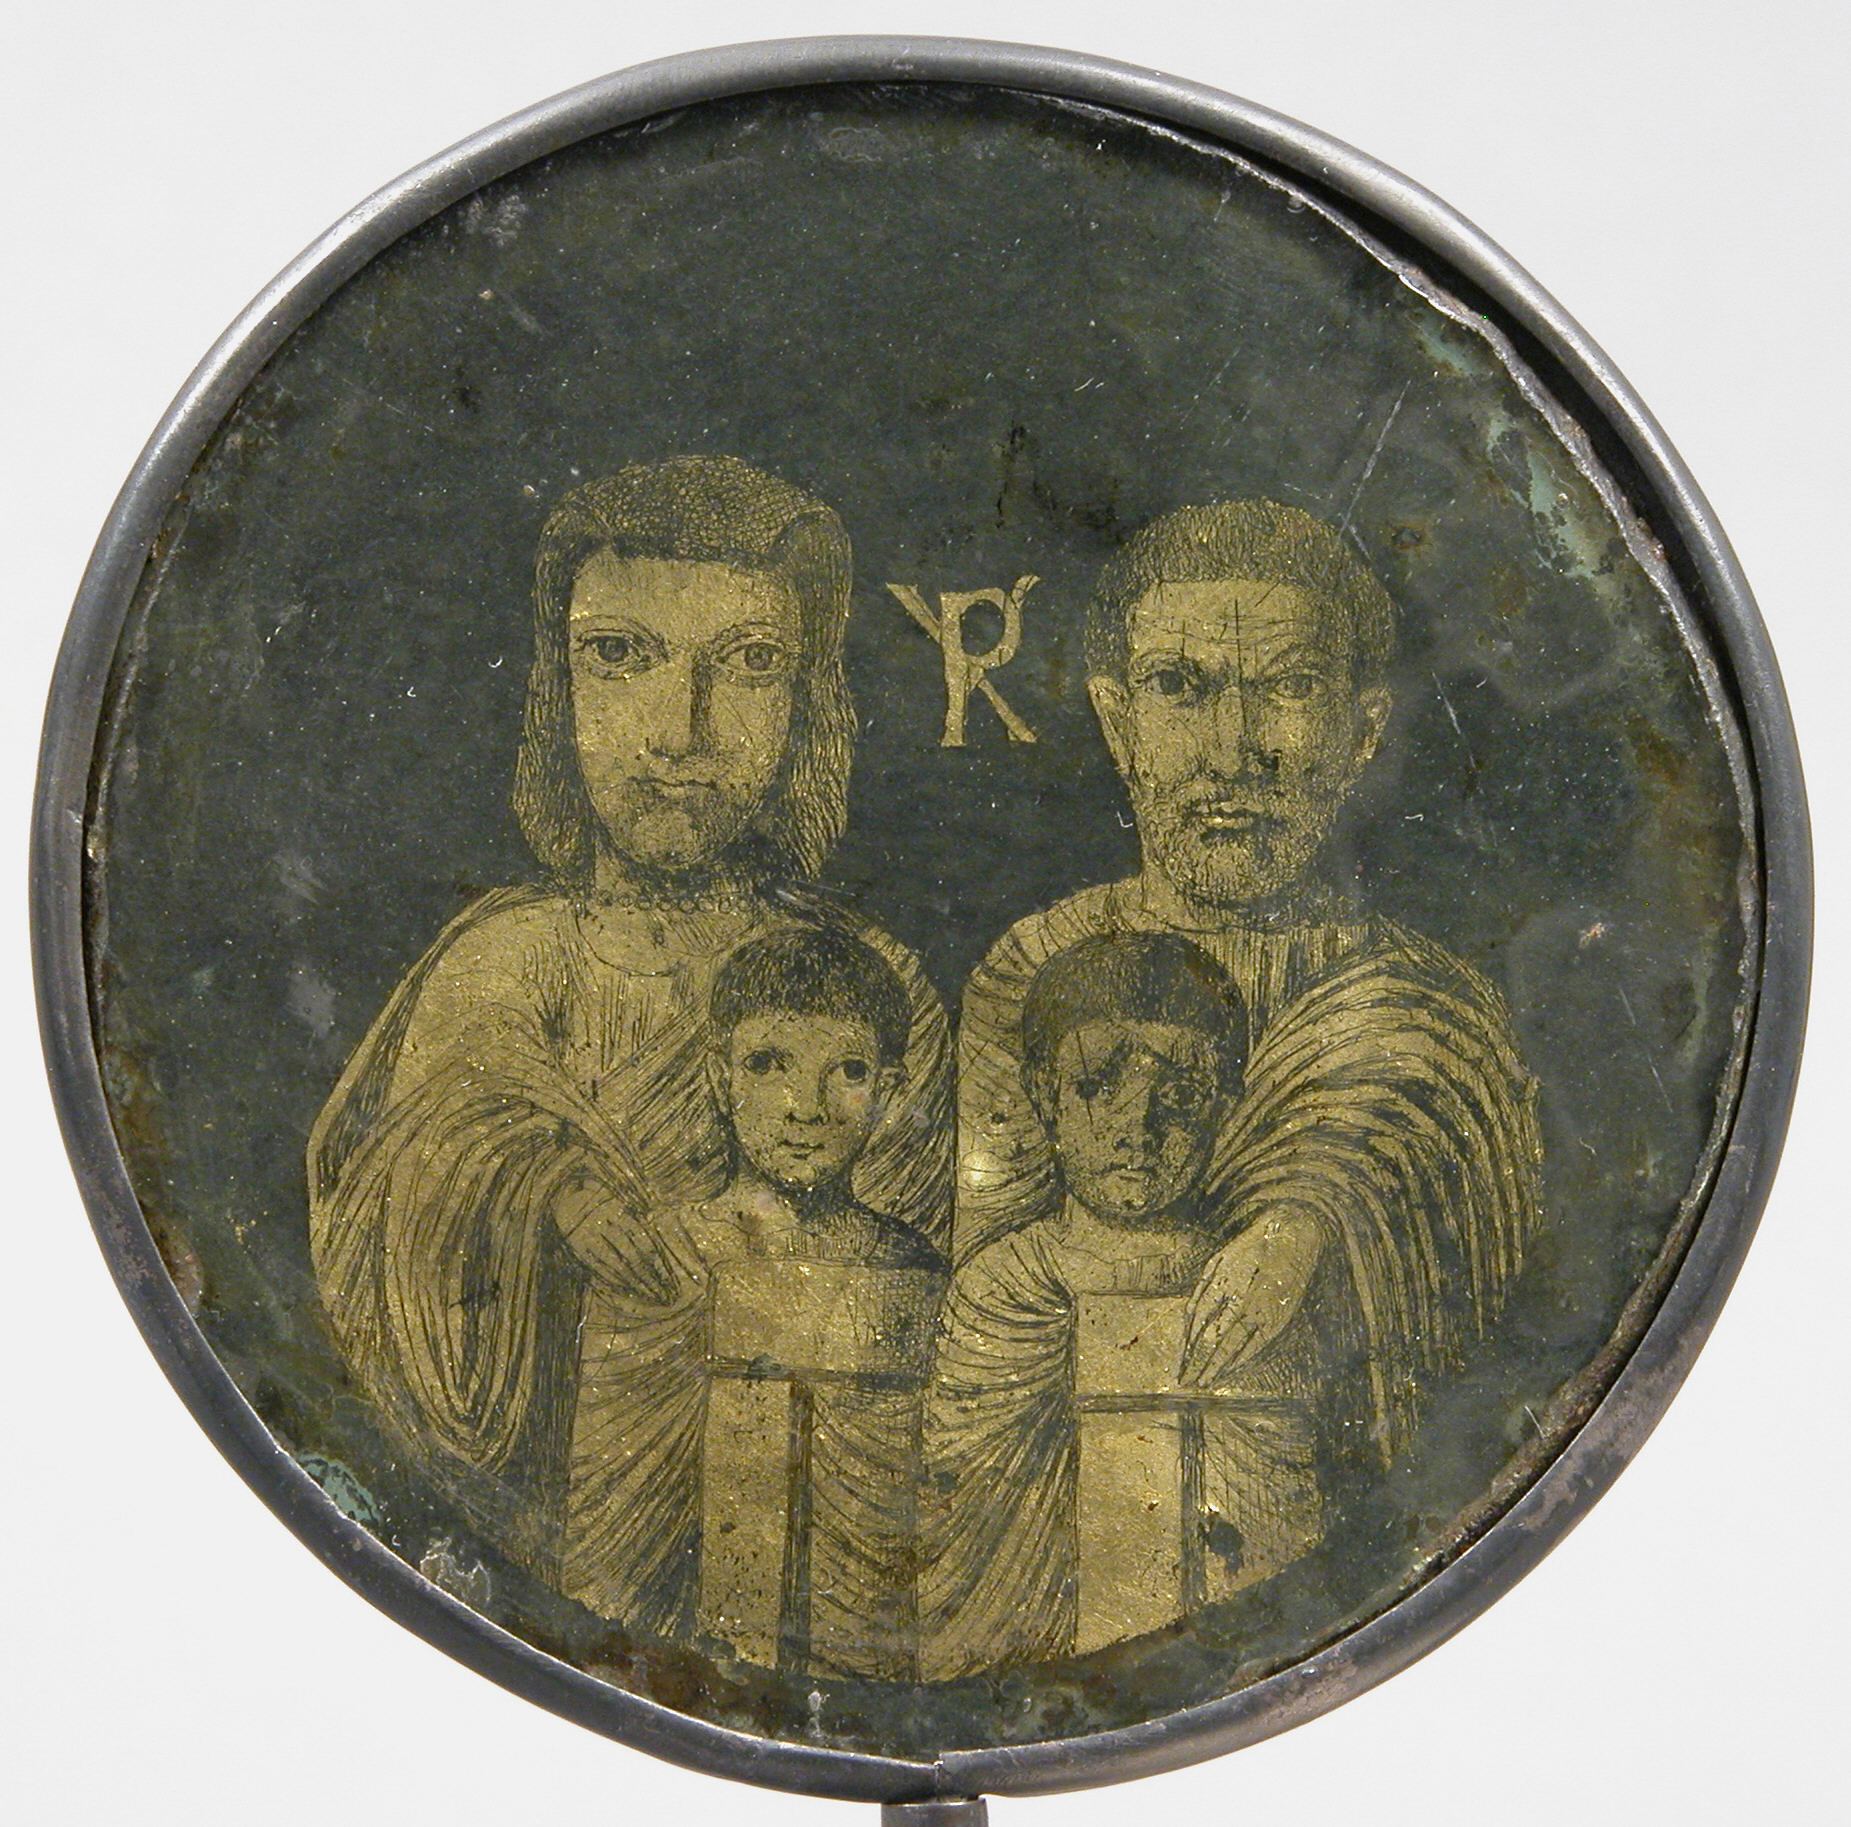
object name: medallion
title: Medallion with Family Portrait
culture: italian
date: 1701-1800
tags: medallions